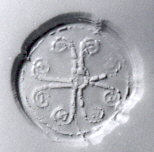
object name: stamp seal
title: Hemispheroid seal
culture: egyptian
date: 2150-2030 BCE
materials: stone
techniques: glazing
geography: egypt